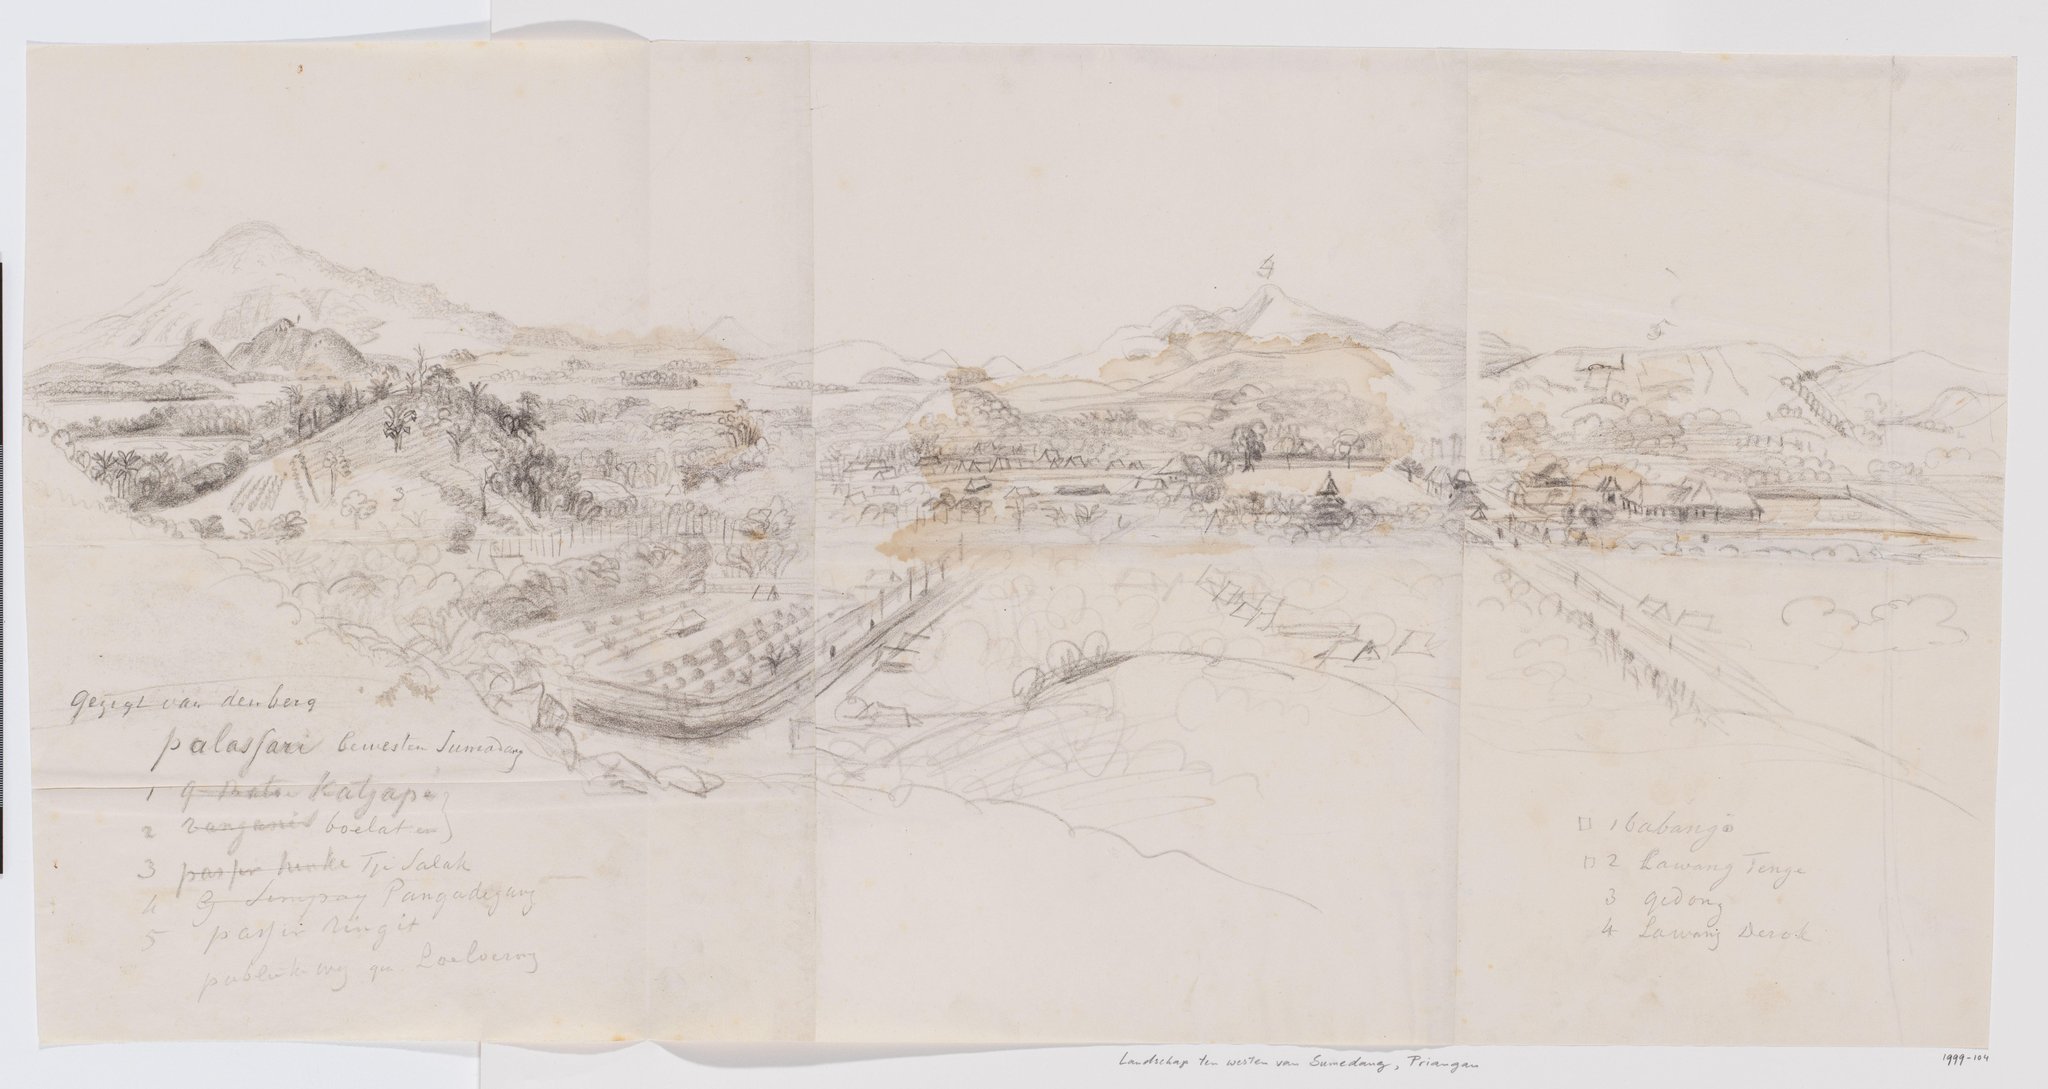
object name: drawing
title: Landschap ten westen van Sumedang, Priangan, West-Java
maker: adrianus johannes bik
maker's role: draughtsman, print maker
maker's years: 1790-1872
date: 1816-1846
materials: chalk, paper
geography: west java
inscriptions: inscription: ‘gezigt van den berg/ Palassari bewesten Sumadang/ 1 Katjapé/ 2 Boelat/ 3 Tji Salak/ 4 Pangadegang/ 5 Passir Ringit/ publieke weg. Loeloerong; 1 Babango/ 2 Lawang Tenge/ 3 Gedong/ Lawang Derok’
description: artikel over deze collectie in Bulletin van het Rijksmuseum 49 [2001], nr. 4, pp 342 e.v.